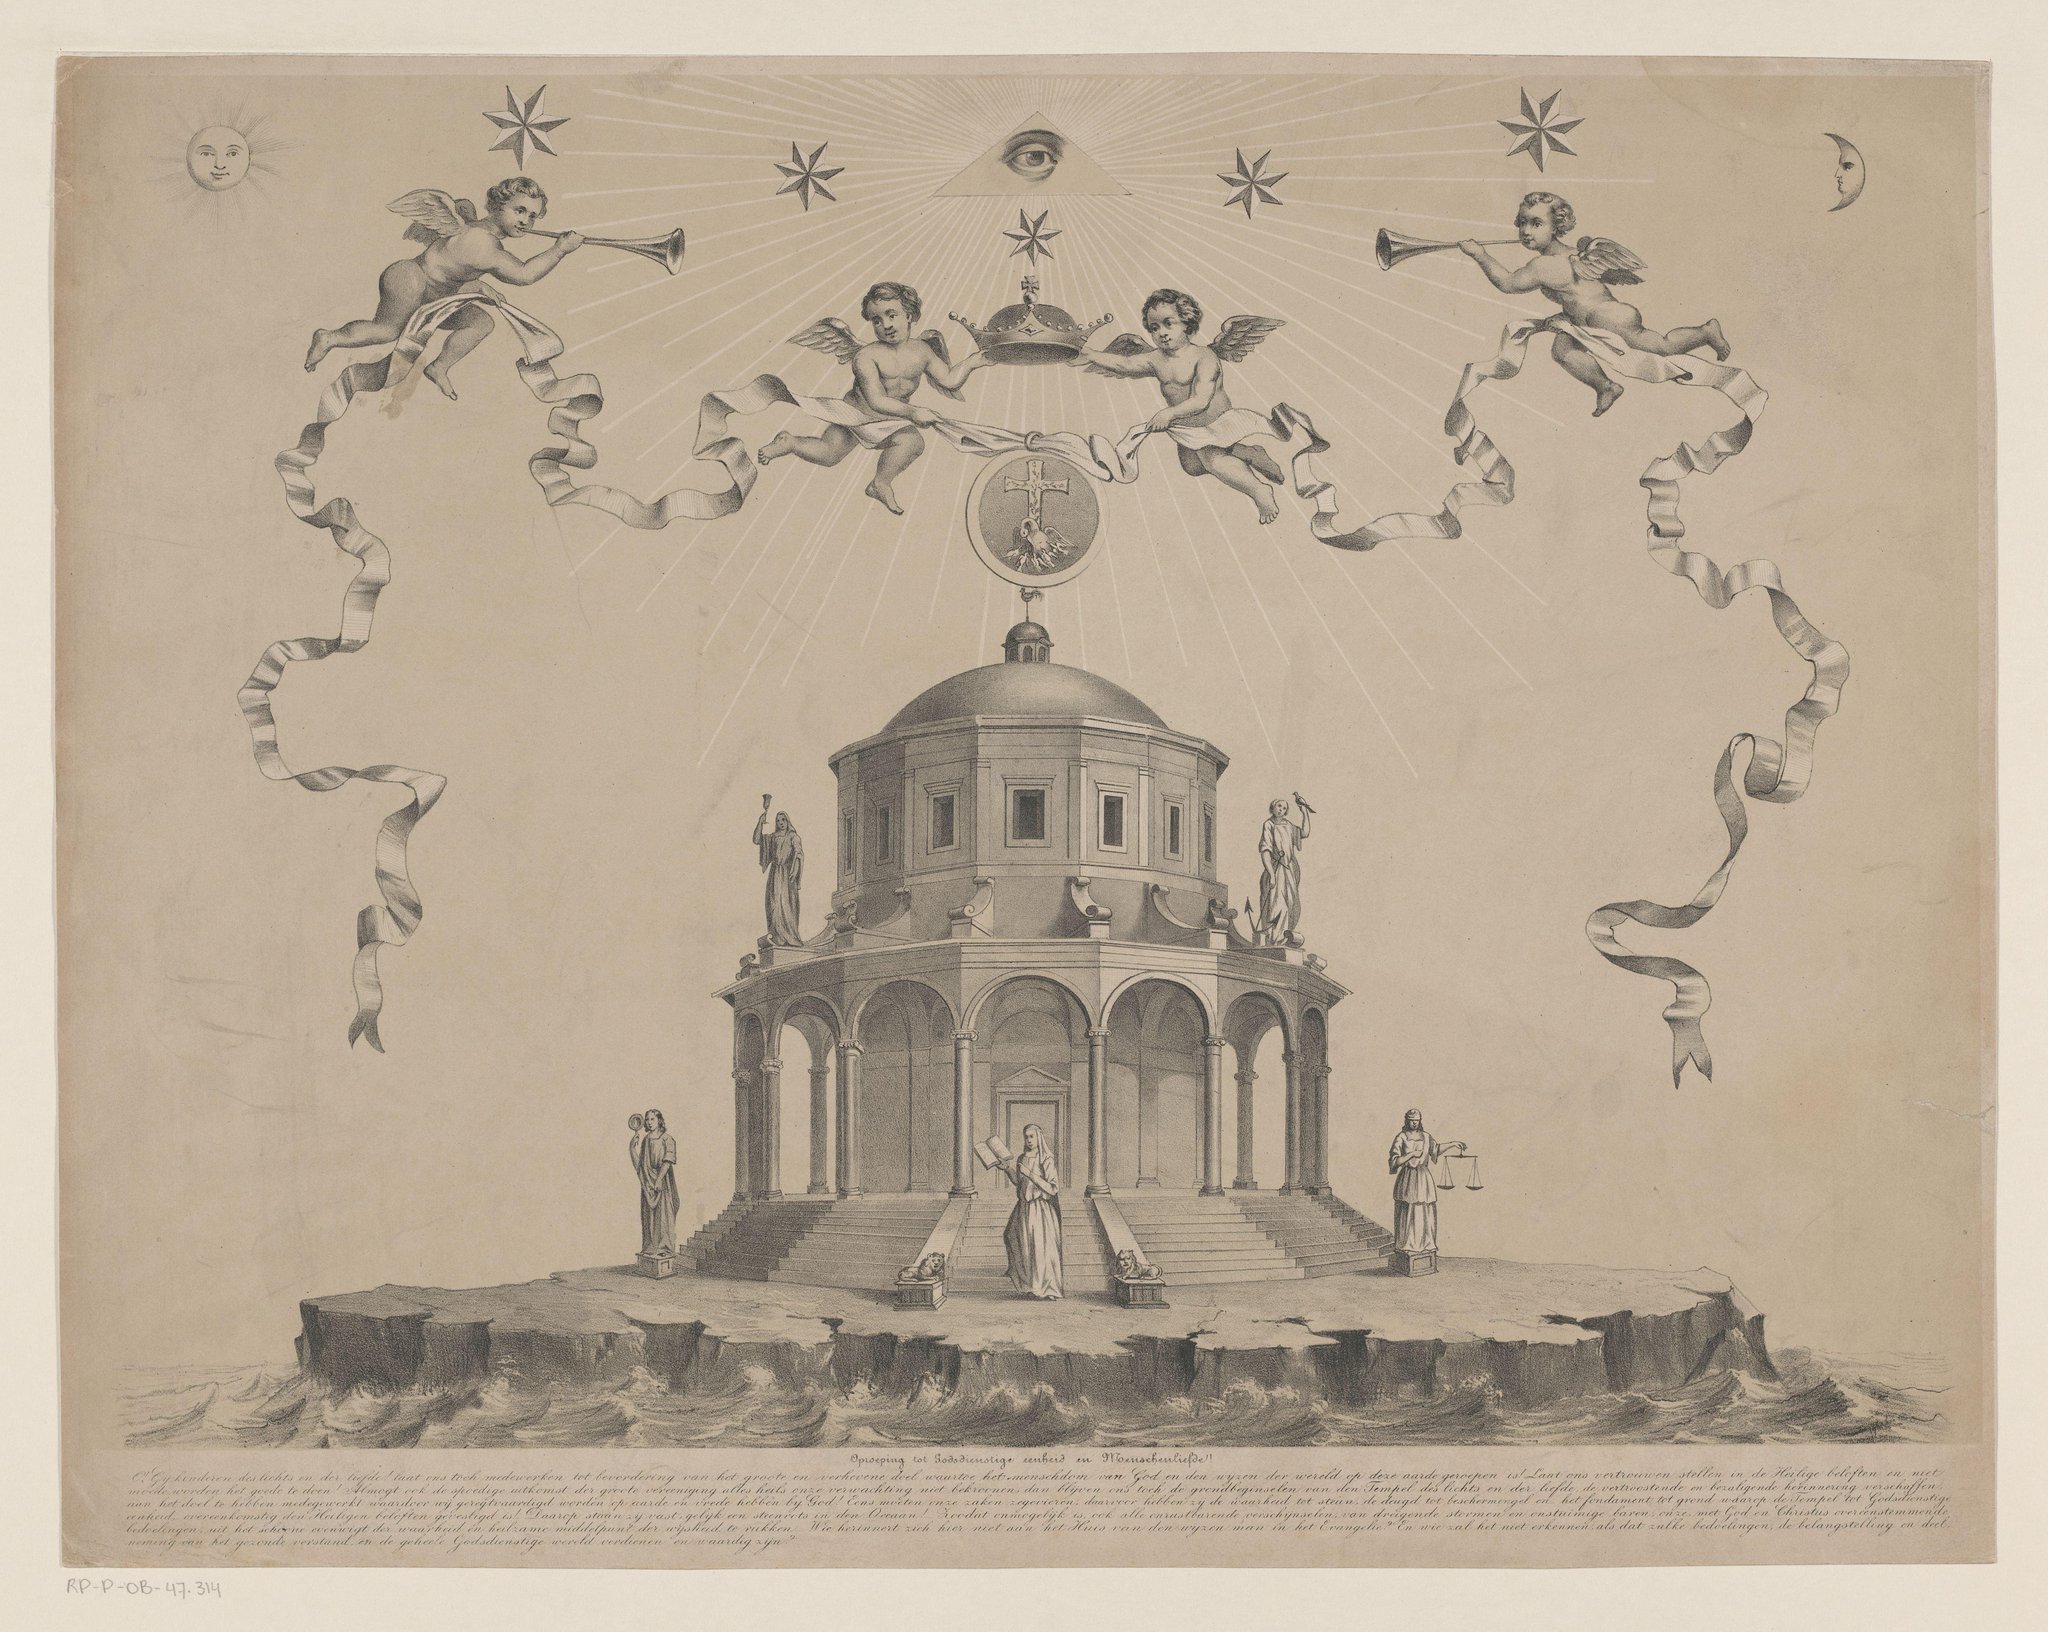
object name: print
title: Vrouw met boek voor tempel met deugden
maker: Anonymous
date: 1809-1900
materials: paper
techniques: tone lithography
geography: netherlands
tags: 'sapientia' and the seven virtues, i.e. the three theological and the four cardinal virtues, the all-seeing eye, triangle with eye ~ symbol of god the father, cupids: 'amores', 'amoretti', 'putti', the heavens (celestial bodies)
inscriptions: collector's mark: Lugt 2228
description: Een vrouw staat voor de ingang van een ronde tempel op een eiland in zee. Zij wijst op een opengeslagen boek in haar handen. Bij de tempel staan de vier deugden Geloof, Hoop, Voorzichtigheid en Rechtvaardigheid. Boven de tempel vliegen vier putti met bazuinen, een kroon en een lint waaraan een medaillon met kruis en pelikaan die zijn jongen voedt hangt. Aan de bovenzijde de zon, maan en sterren aan weerszijden van het alziend oog. In de ondermarge een zesregelige Nederlandse tekst.